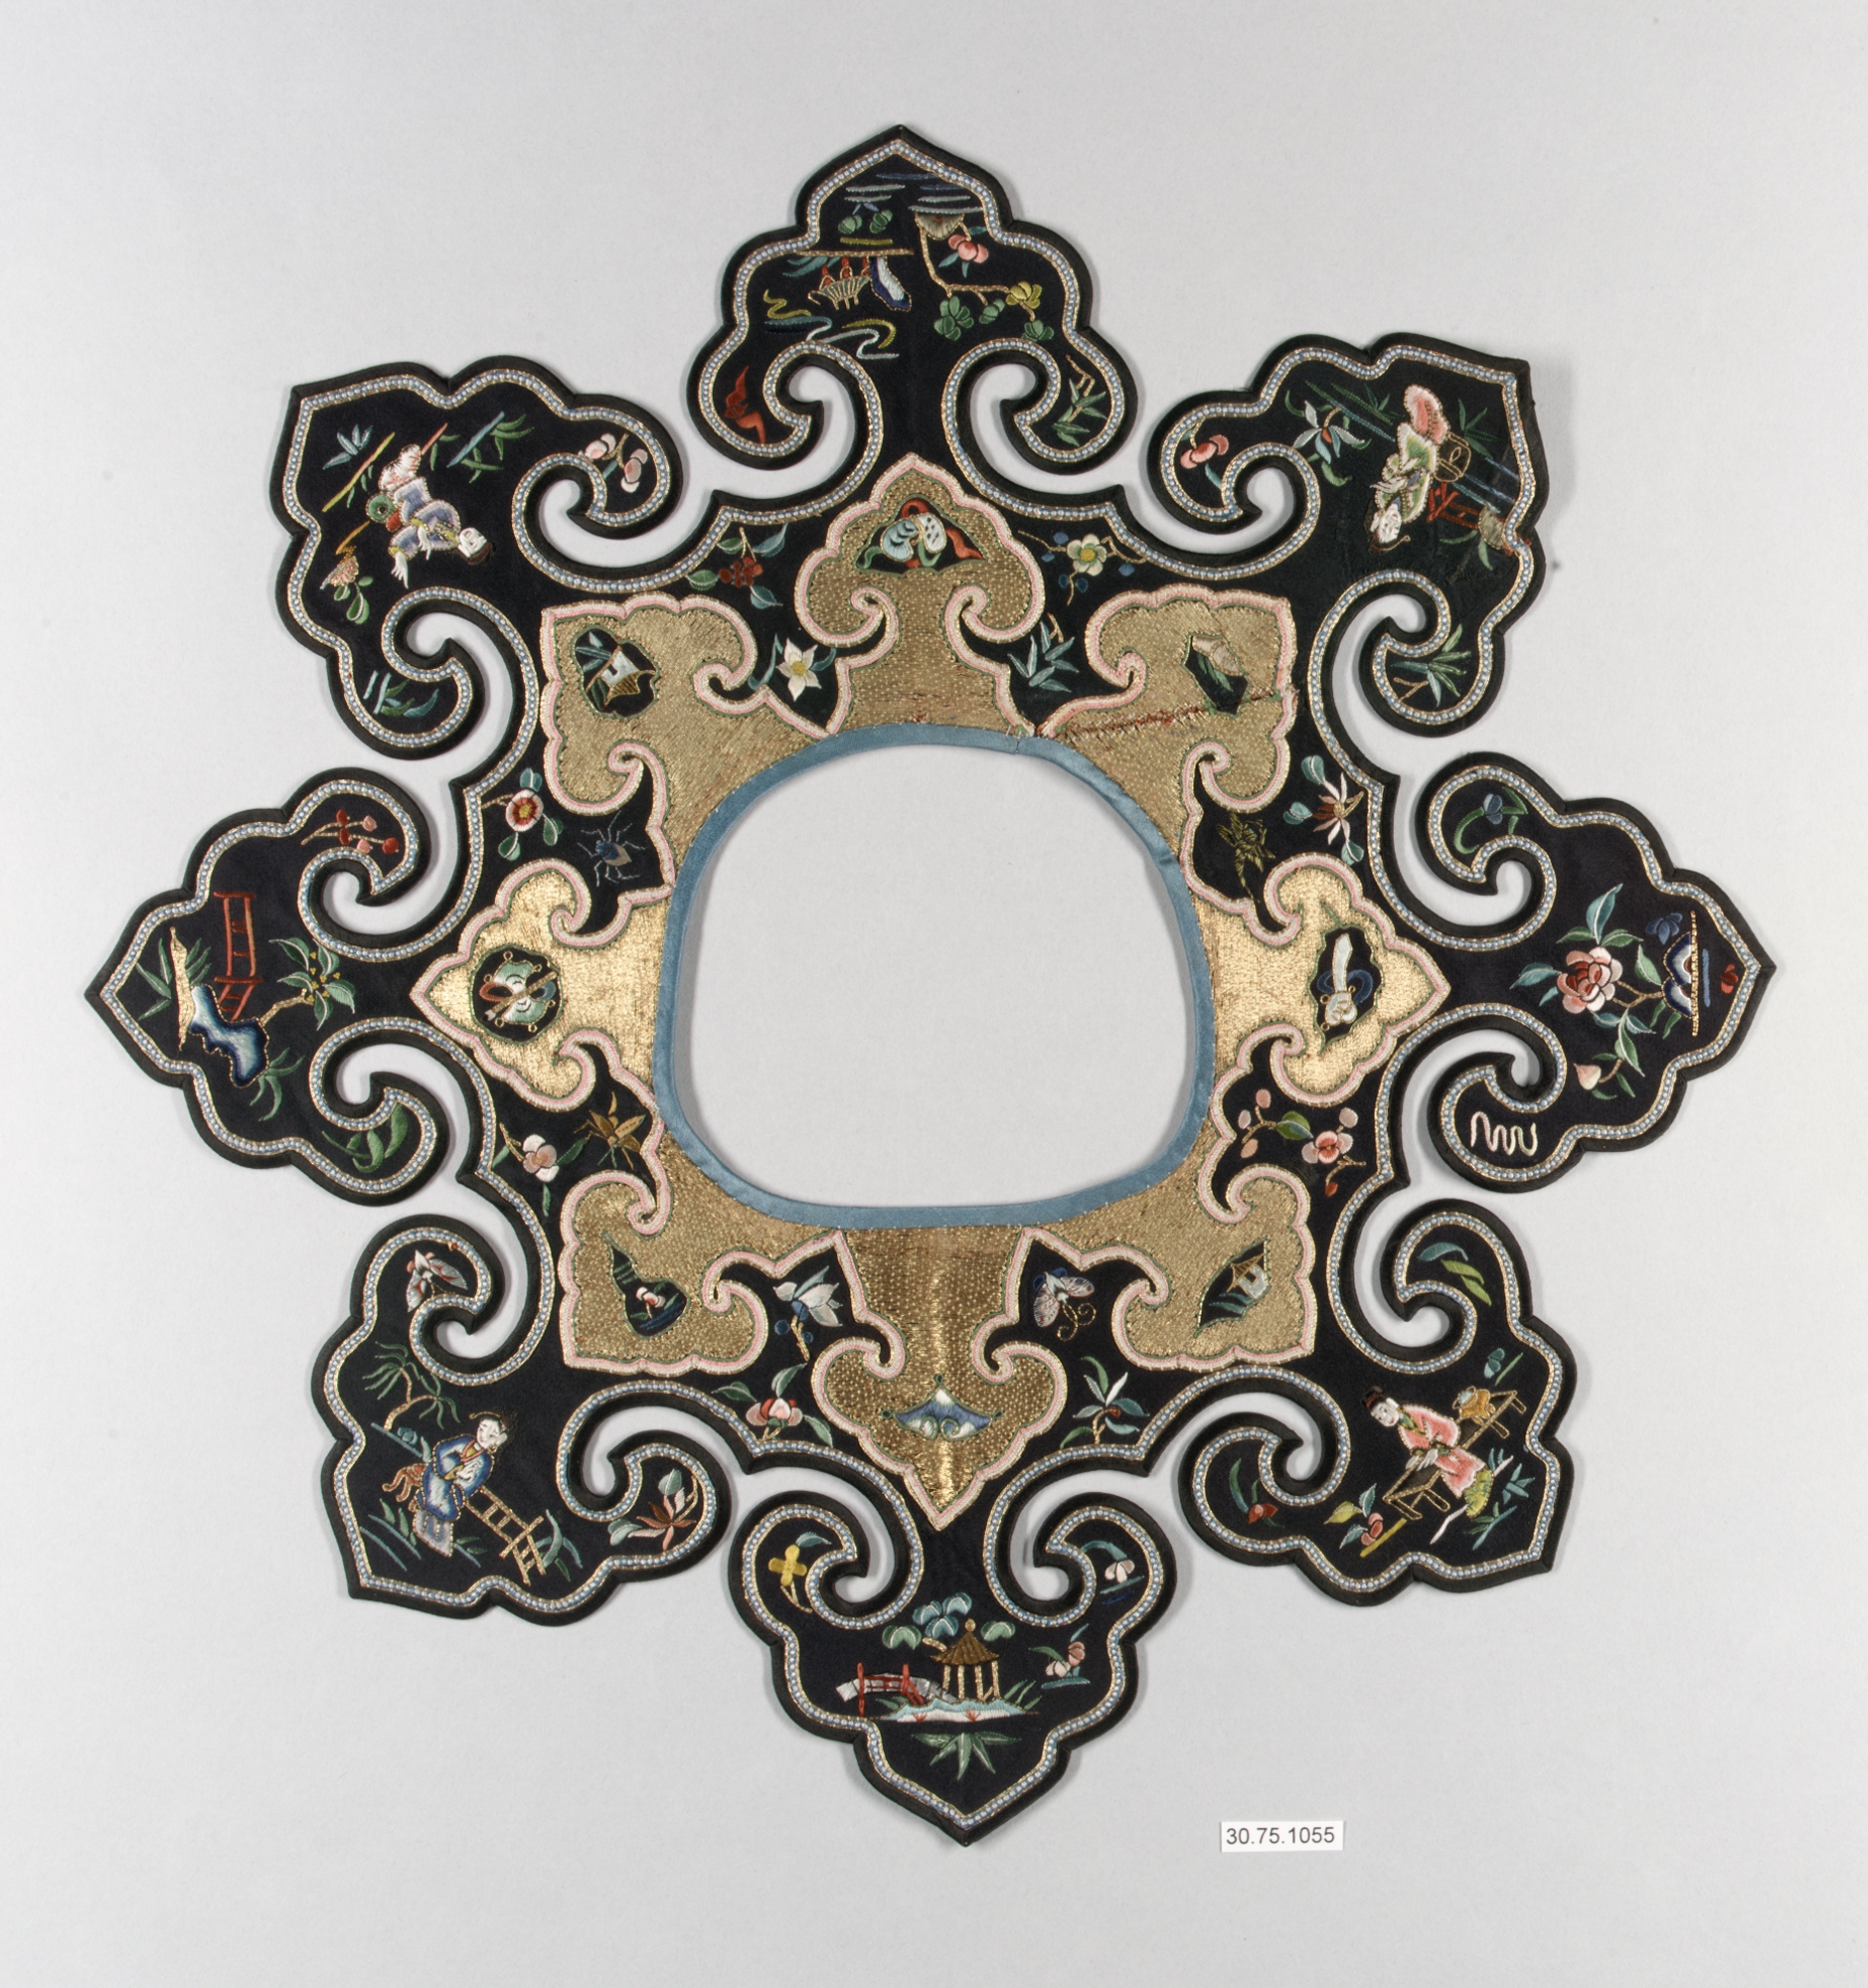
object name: collar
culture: chinese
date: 1644-1911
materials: metal thread, silk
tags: human figures,insects,flowers